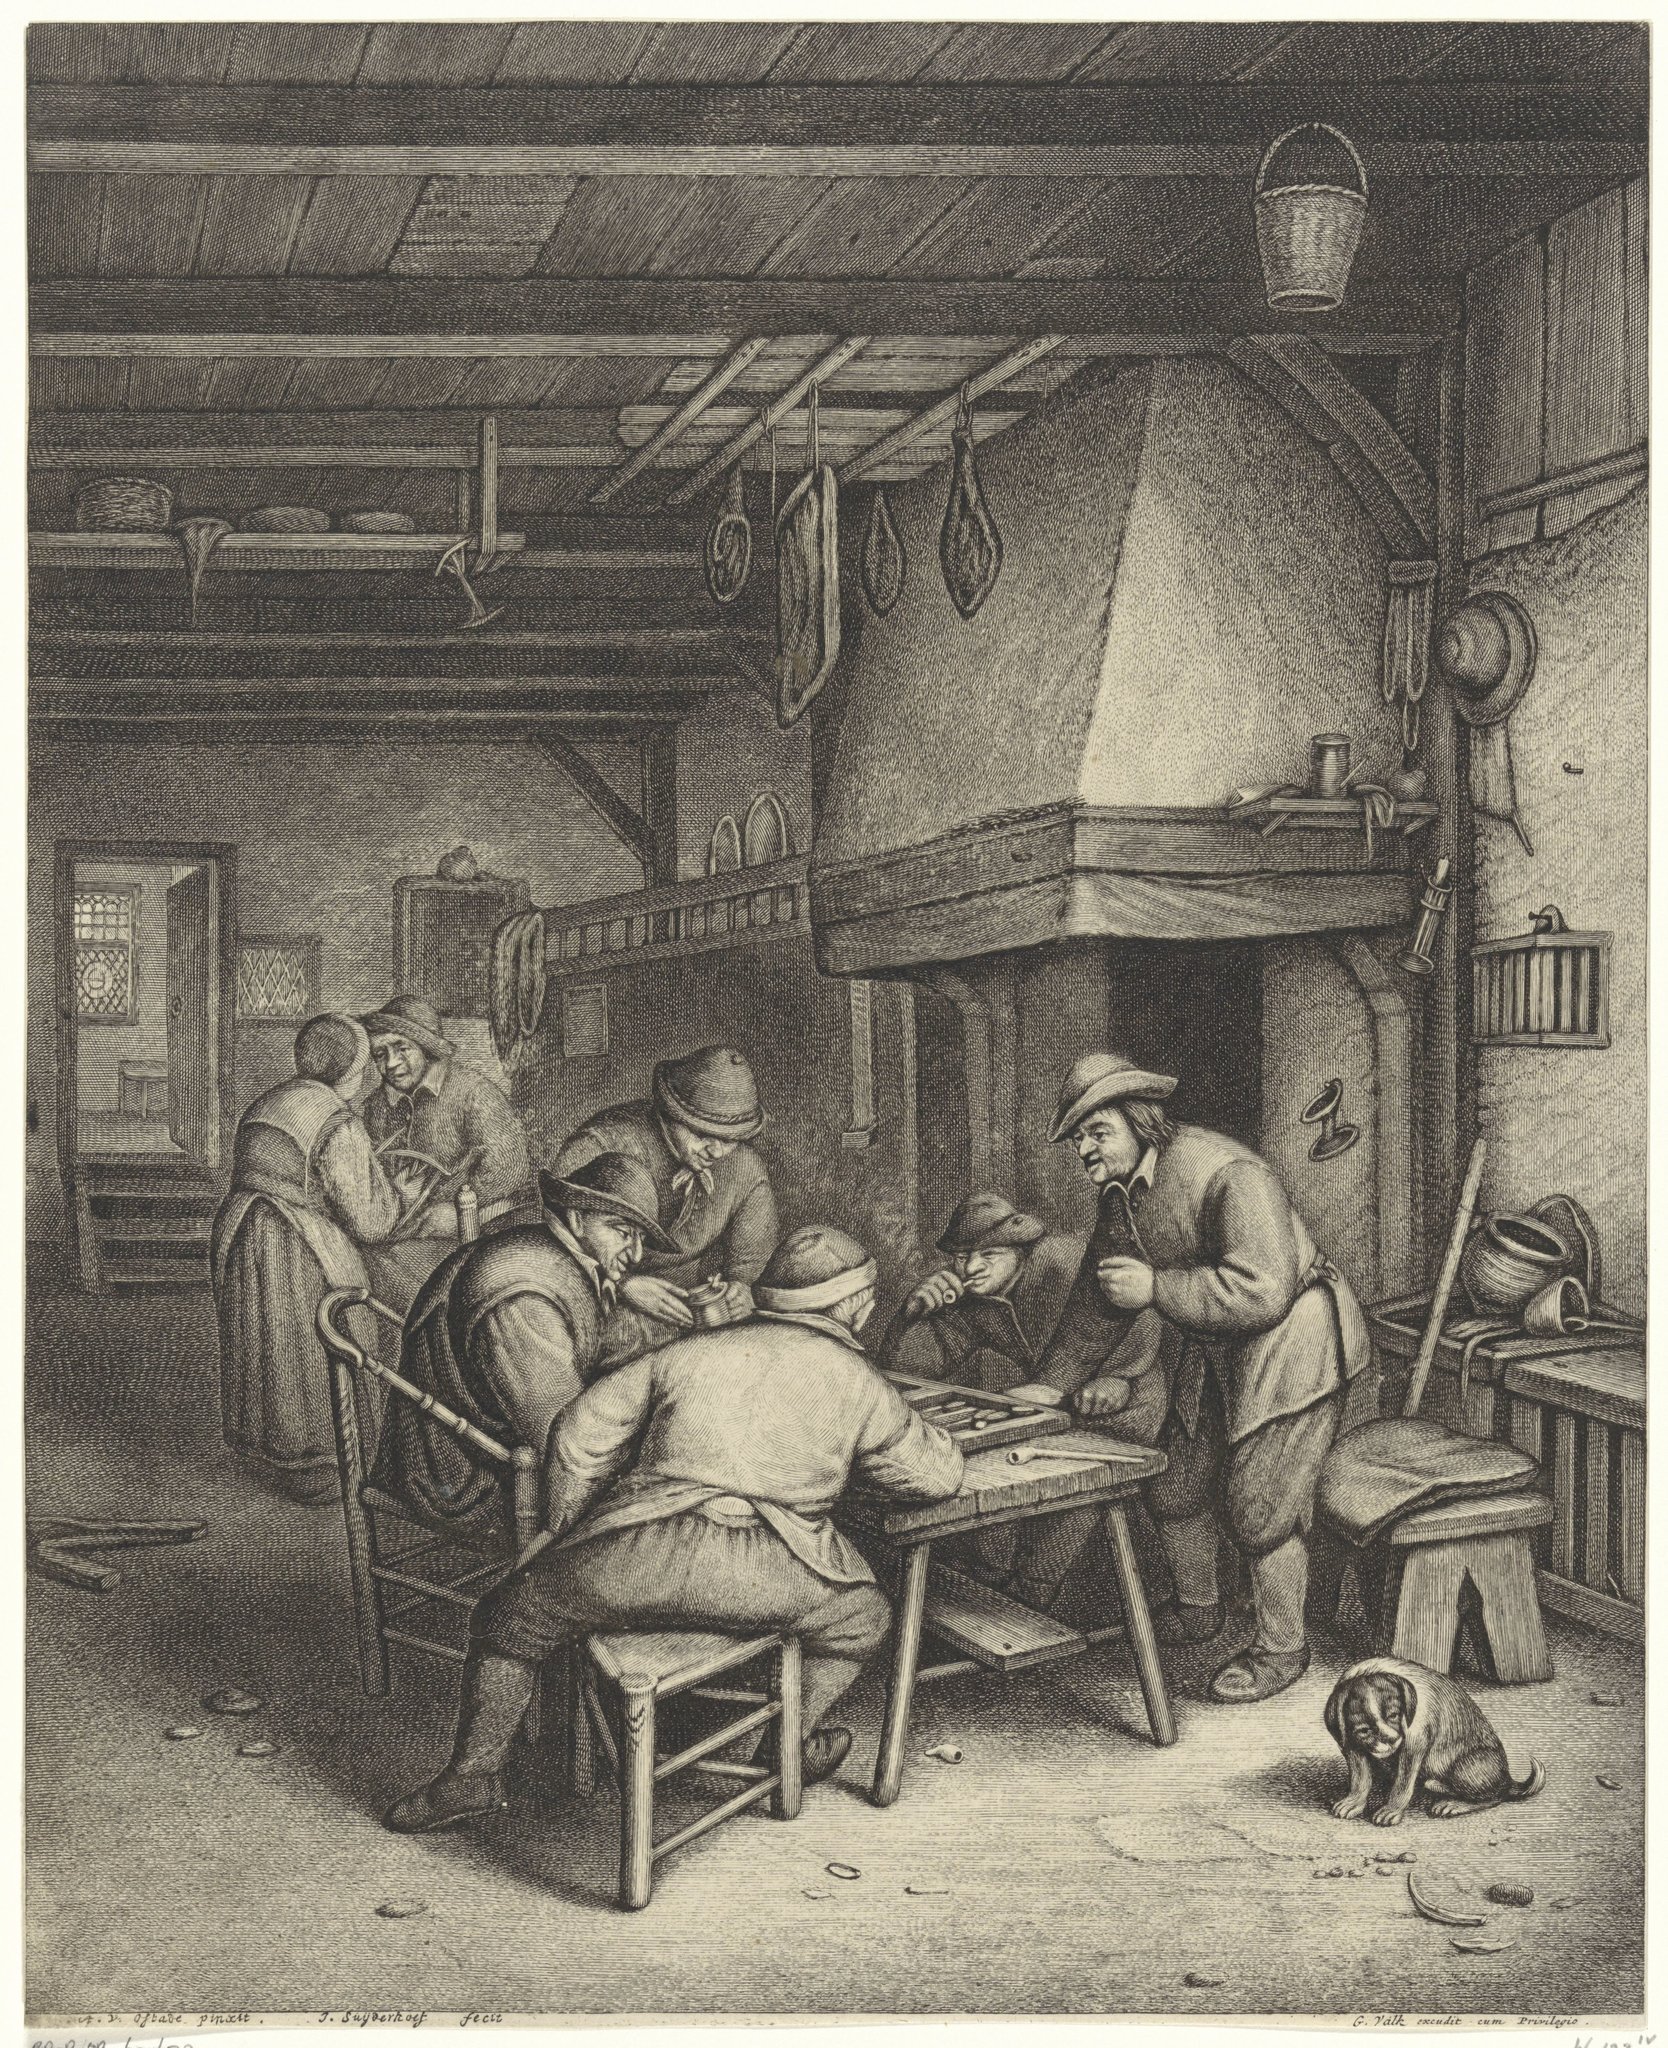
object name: print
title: Boereninterieur met triktrakspelers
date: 1670-1726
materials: paper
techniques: engraving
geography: amsterdam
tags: pipe ~ tobacco, open hearth, fire-place, backgammon, tric-trac, dog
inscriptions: collector's mark: Lugt 240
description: Boeren spelen triktrak of backgammon aan een tafel bij een haard. Rechts op de voorgrond een hond. Op de achtergrond een man en een vrouw.